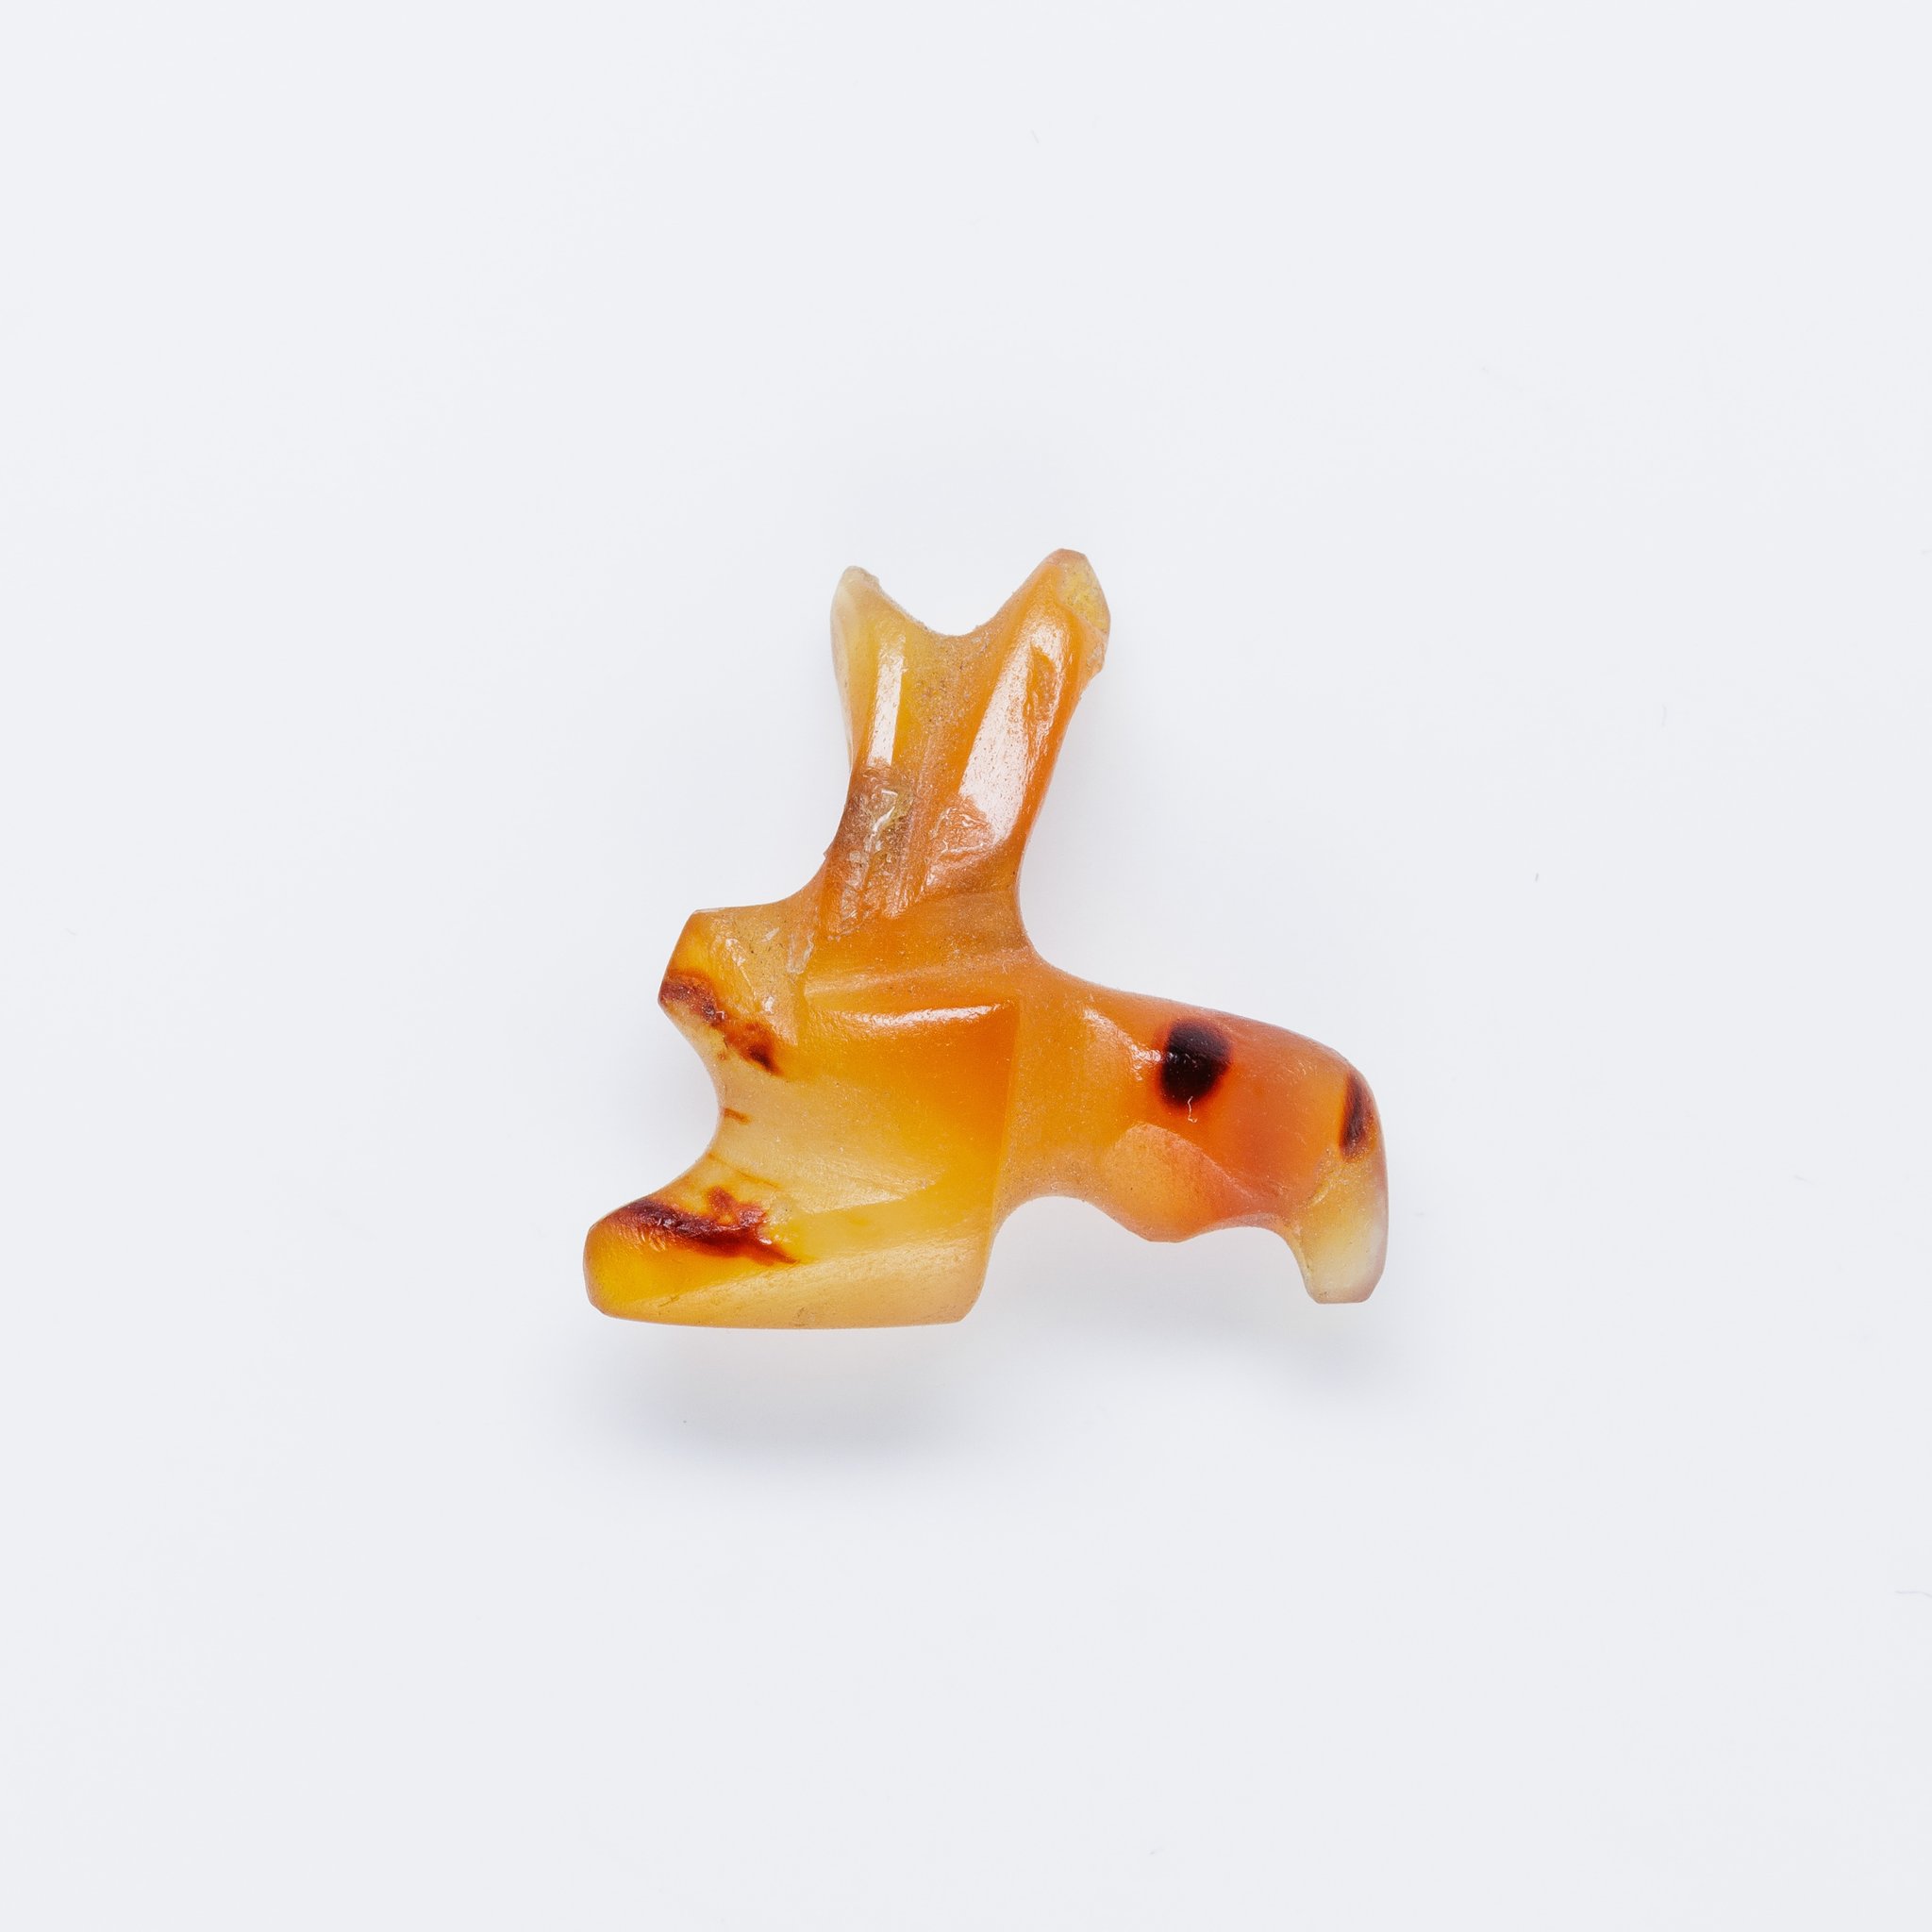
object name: amulet, bee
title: Bee amulet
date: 2150-1950 BCE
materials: gemstone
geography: southern upper egypt